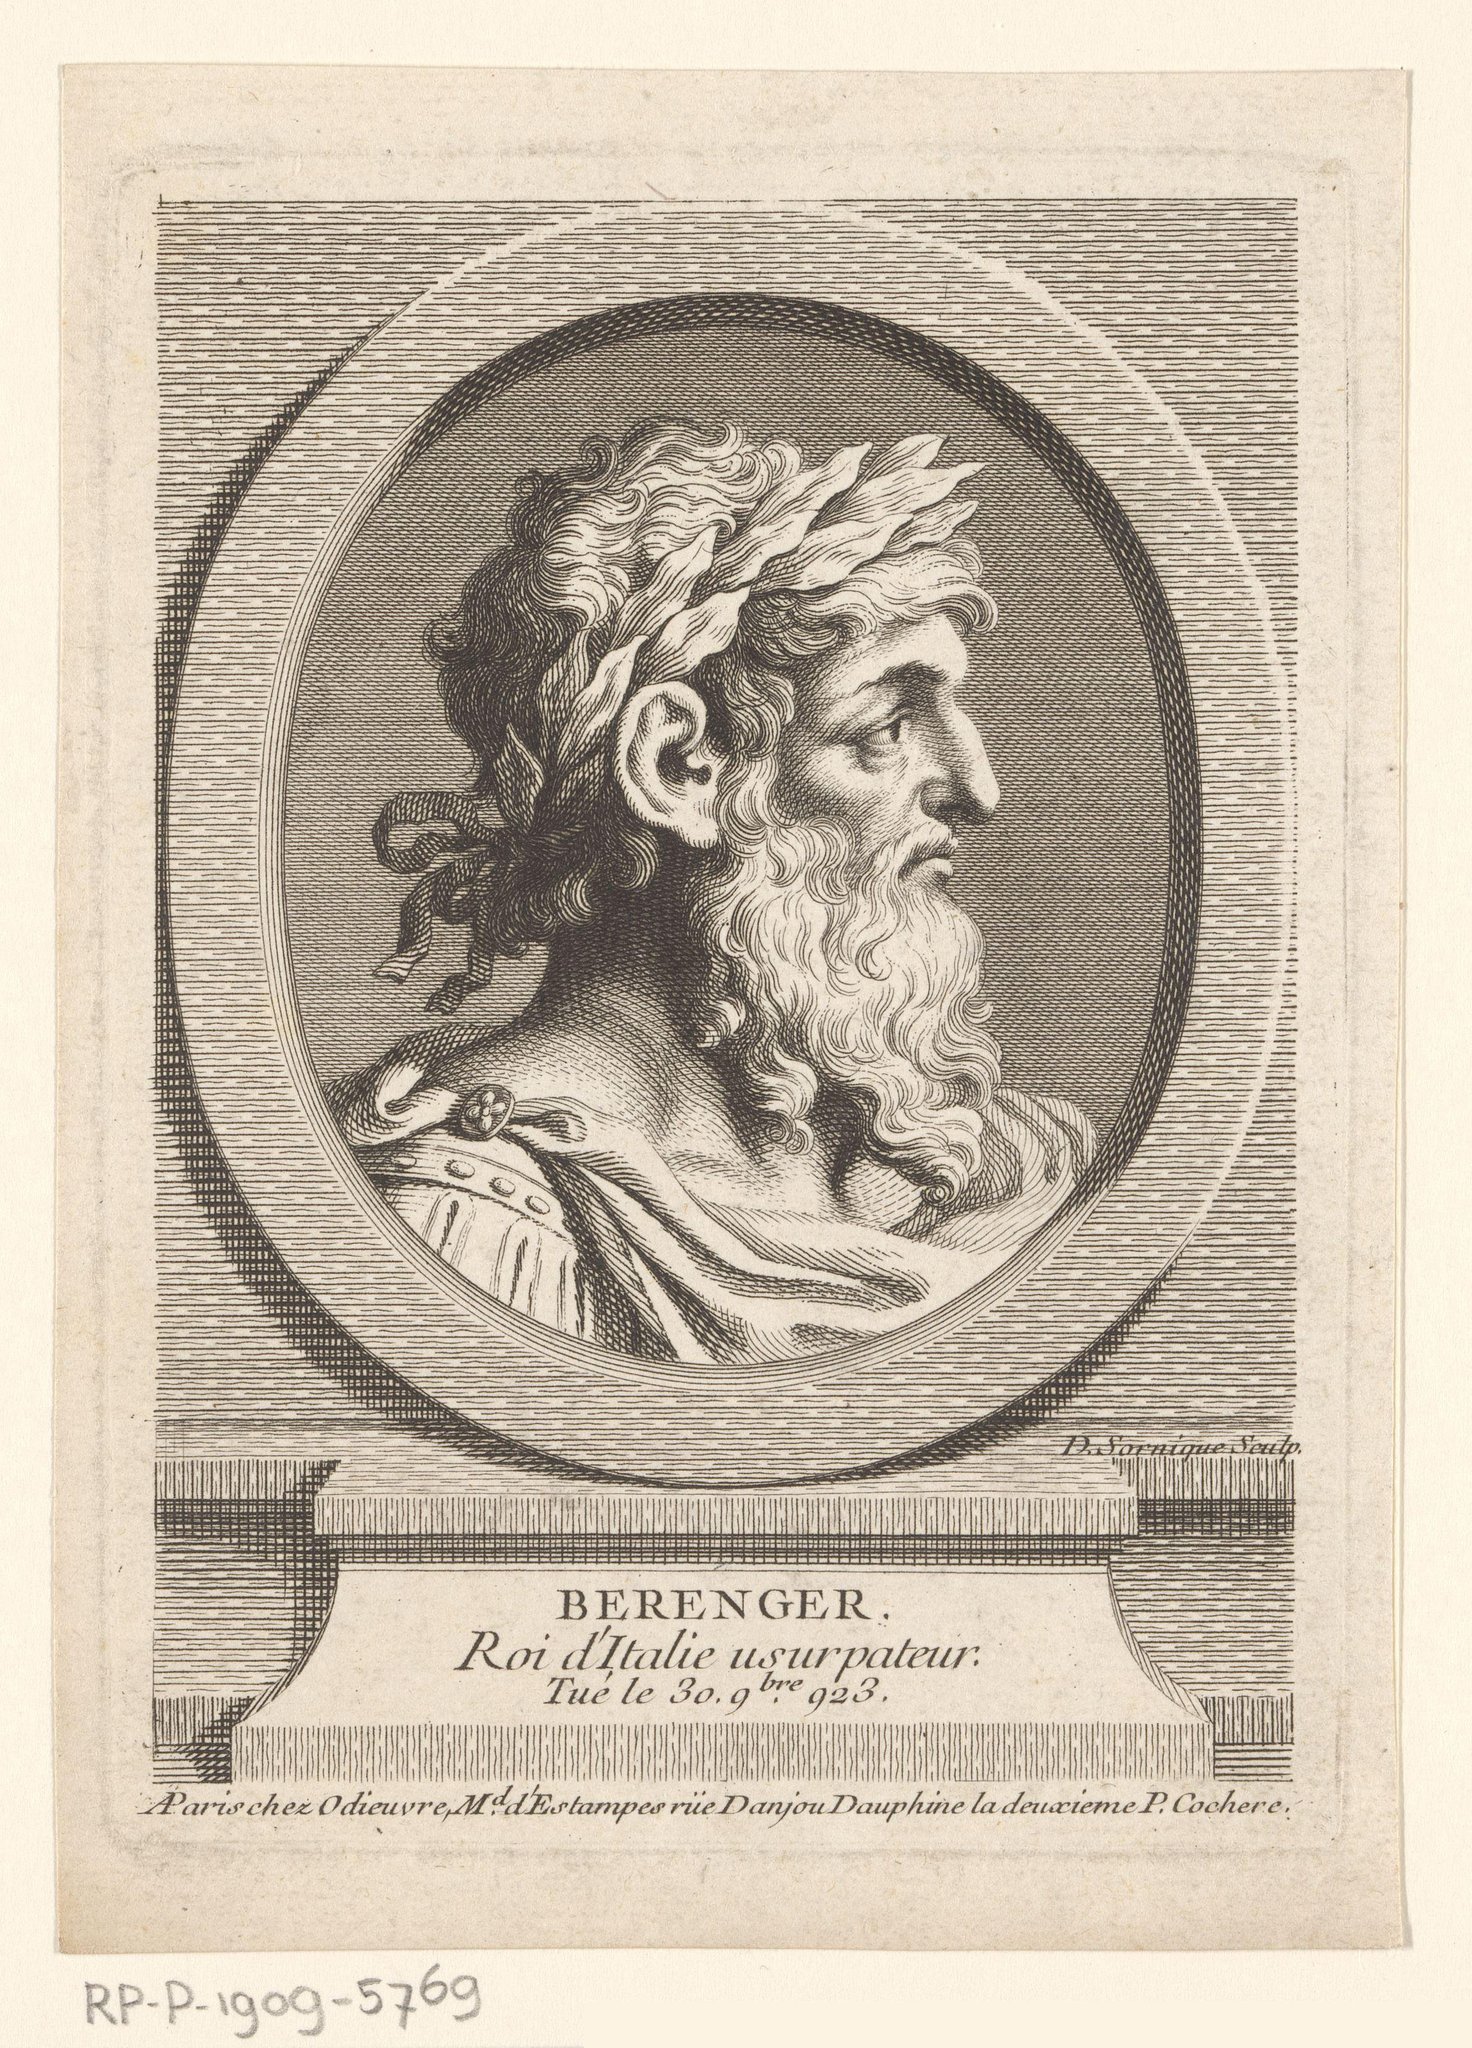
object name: print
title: Portret van koning Berengarius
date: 1755-1756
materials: paper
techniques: engraving, etching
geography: paris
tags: historical persons, king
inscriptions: collector's mark: Lugt 2228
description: Prent uit: Dreux du Radier, Jean-François. L'Europe illustré, contenant l'histoire abregée des souverains, des princes, des prélats, des ministres, (...) en Europe: dans le XVe. siècle compris, jusqu'à présent. Parijs: Michel Odieuvre en André-François Le Breton, 1755-1765.